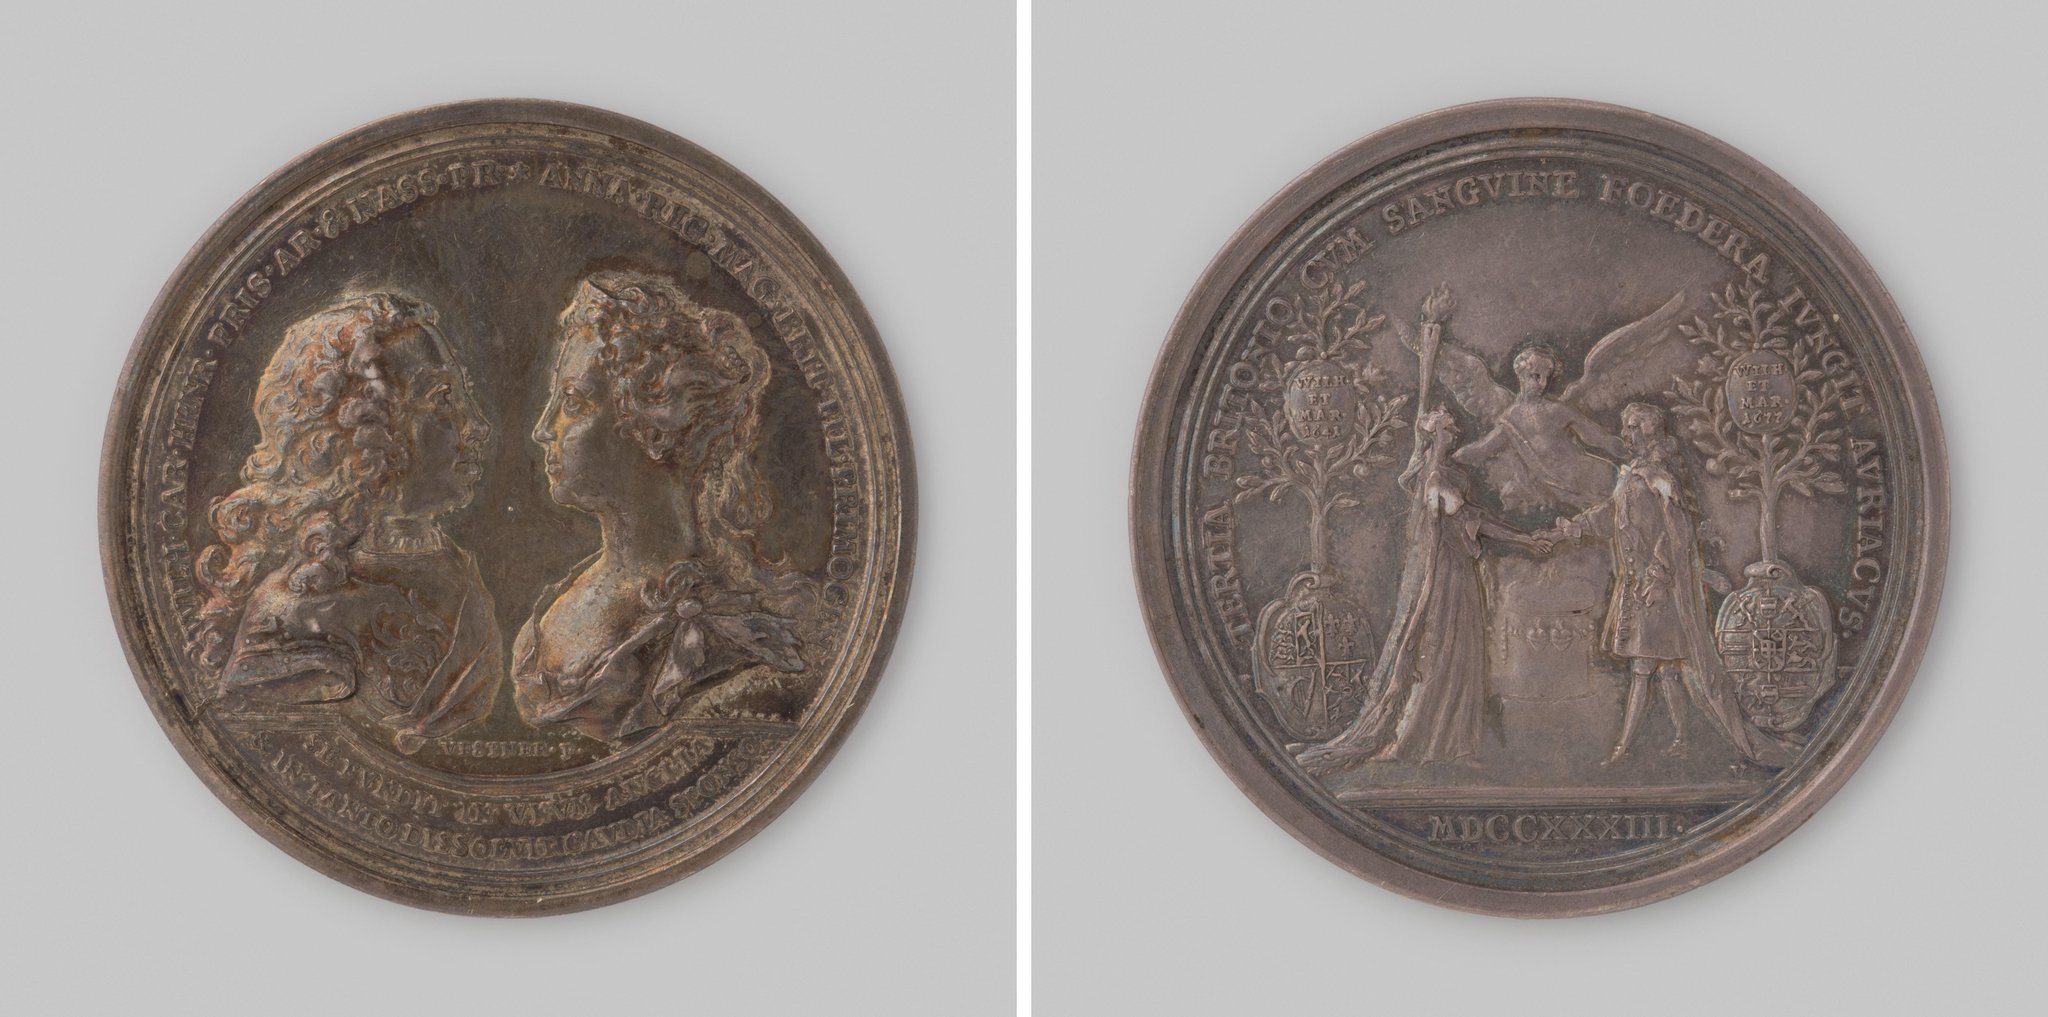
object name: history medal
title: Huwelijk van Willem Karel Hendrik Friso met Prinses Anna van Engeland 1734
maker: georg wilhelm vestner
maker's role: medailleur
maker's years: 1677-1740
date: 1734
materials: silver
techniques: striking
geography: nuremberg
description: Zilveren penning, op de voorzijde de elkaar aanziende portretten van Willem en Anna, met omschrift en afsnedetekst, op de keerzijde de echtelieden en een vliegende genius met toorts bij een altaar, tussen twee oranjebomen waartegen met wapenschilden en tekstbordjes, met omschrift en afsnedetekst.